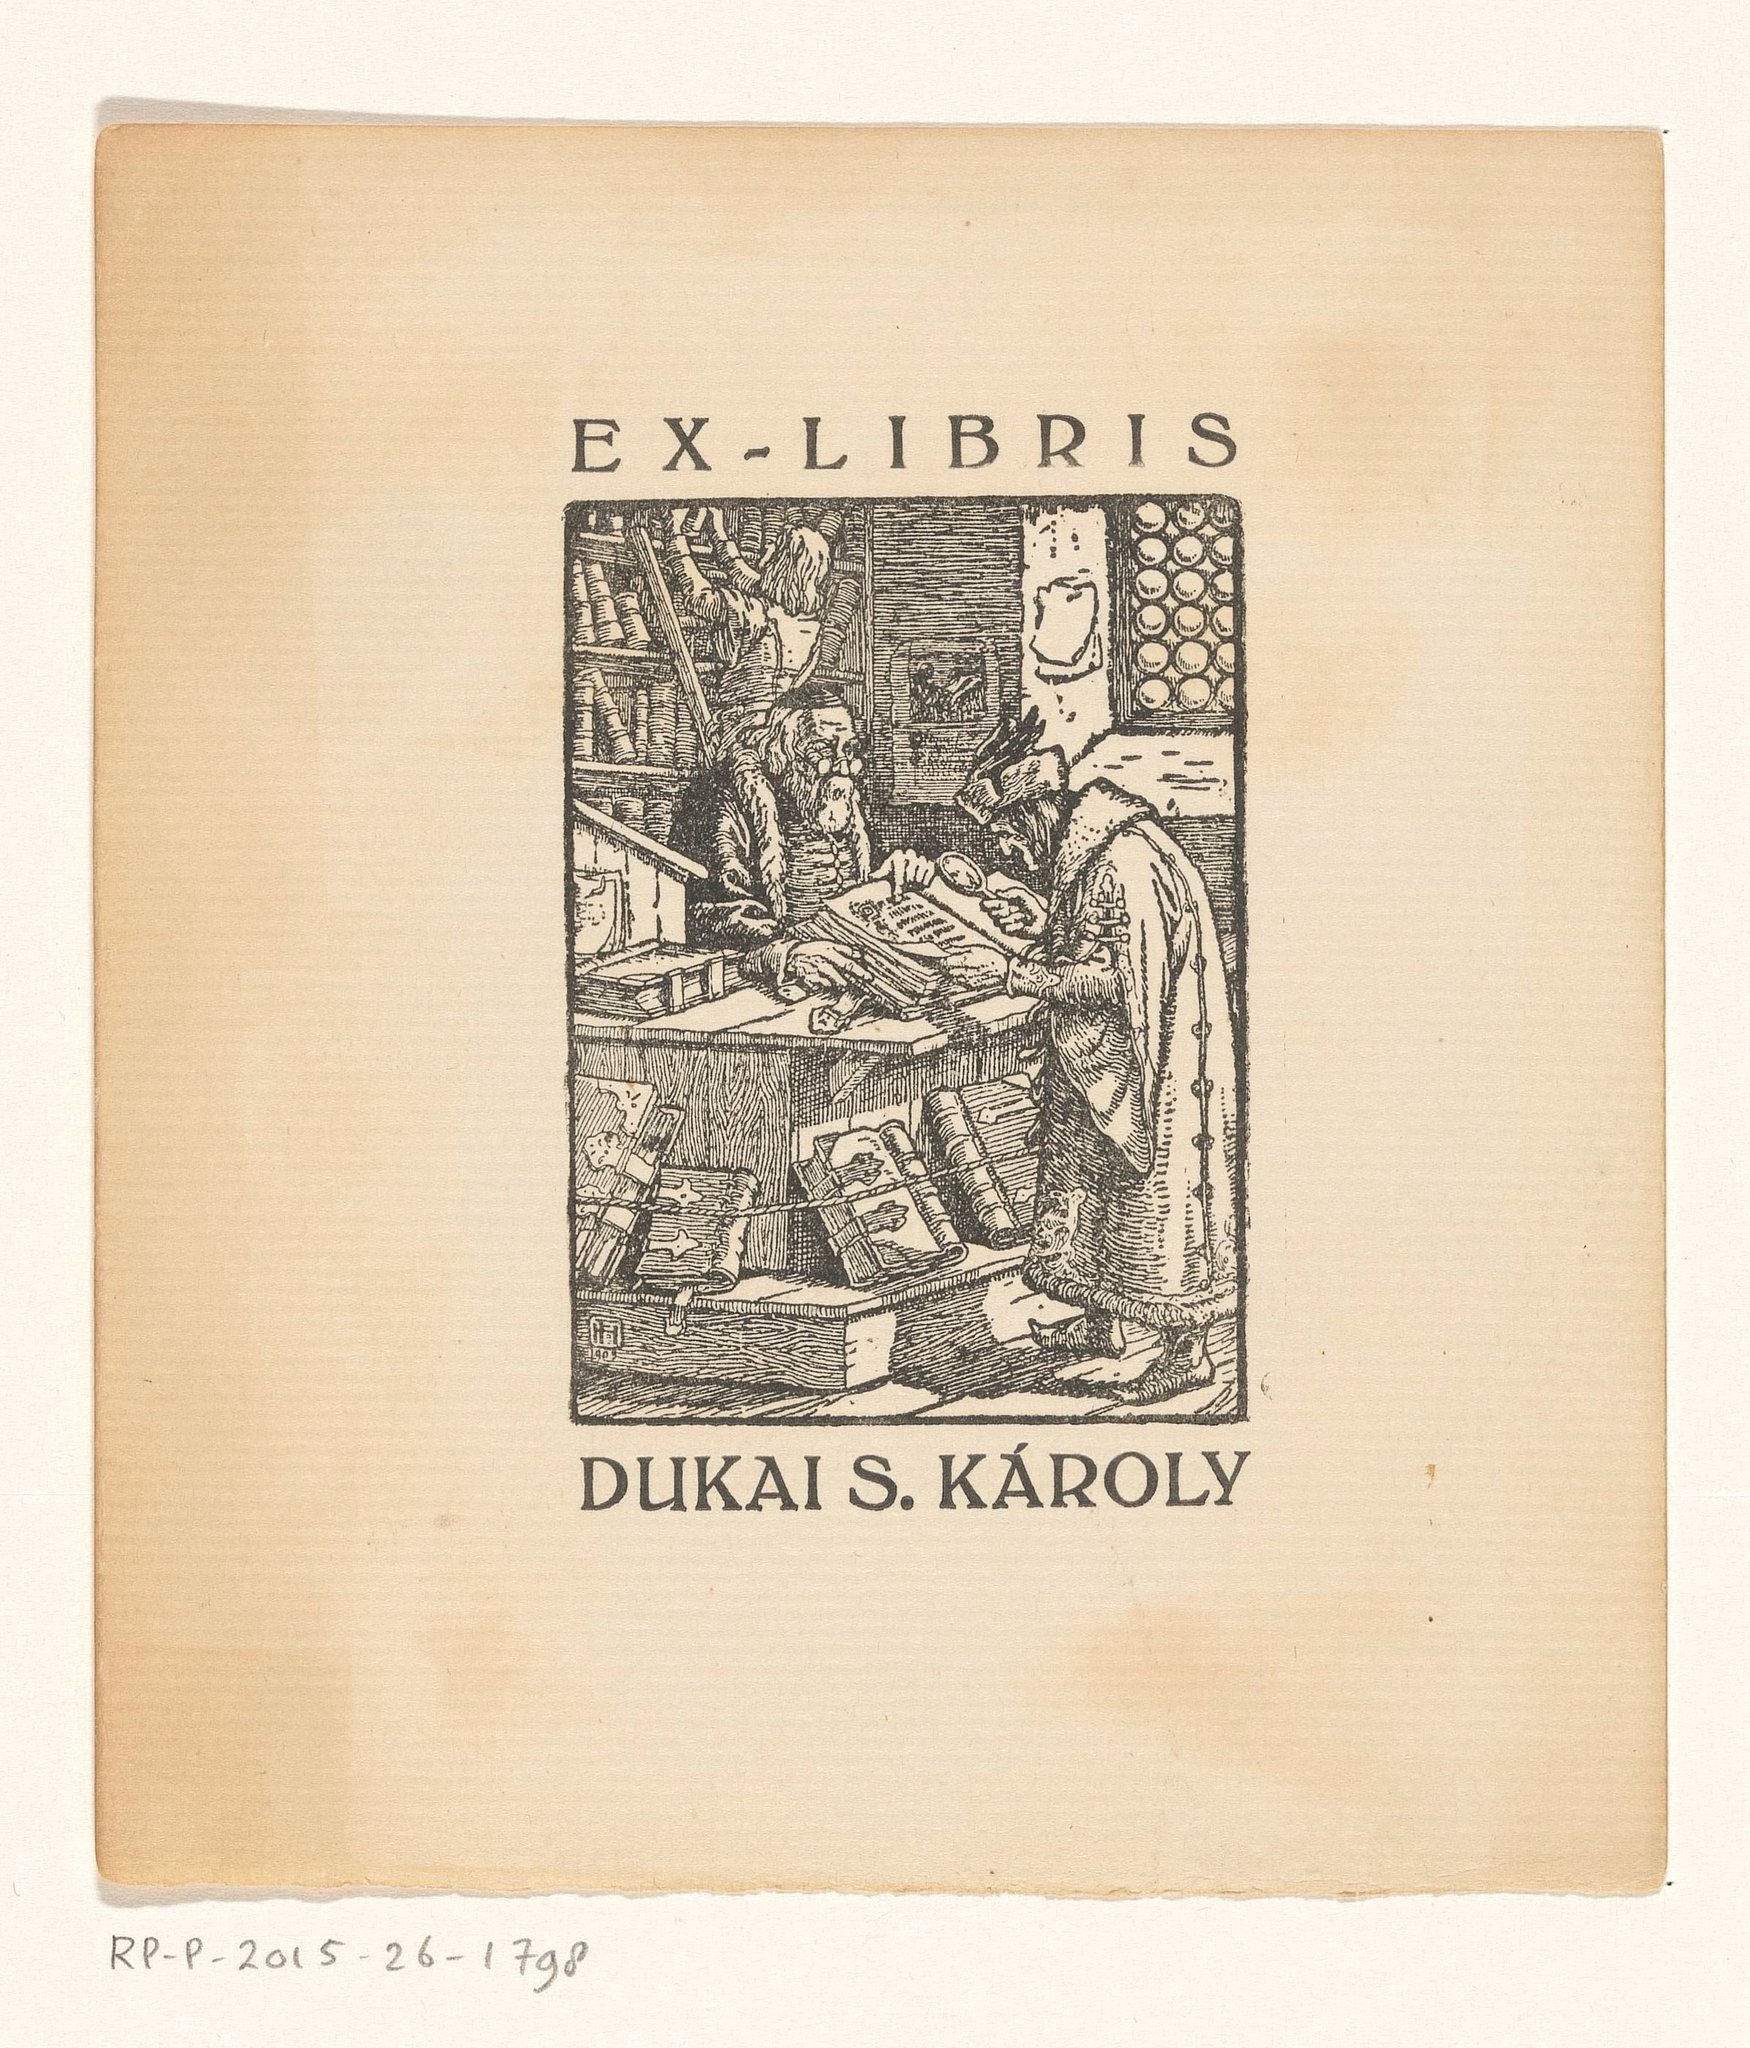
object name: print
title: Ex libris van Dukai S. Károly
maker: Anonymous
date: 1909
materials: paper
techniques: woodcut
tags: magnifying glass, book-shop, bookseller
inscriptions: collector's mark: Lugt 2228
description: Interieur van een zestiende-eeuwse boekhandel. Een klant met een vergrootglas bestudeert een boek dat voor hem op de toonbank ligt. Achter de toonbank de boekhandelaar en een jongen op een ladder voor een boekenkast.